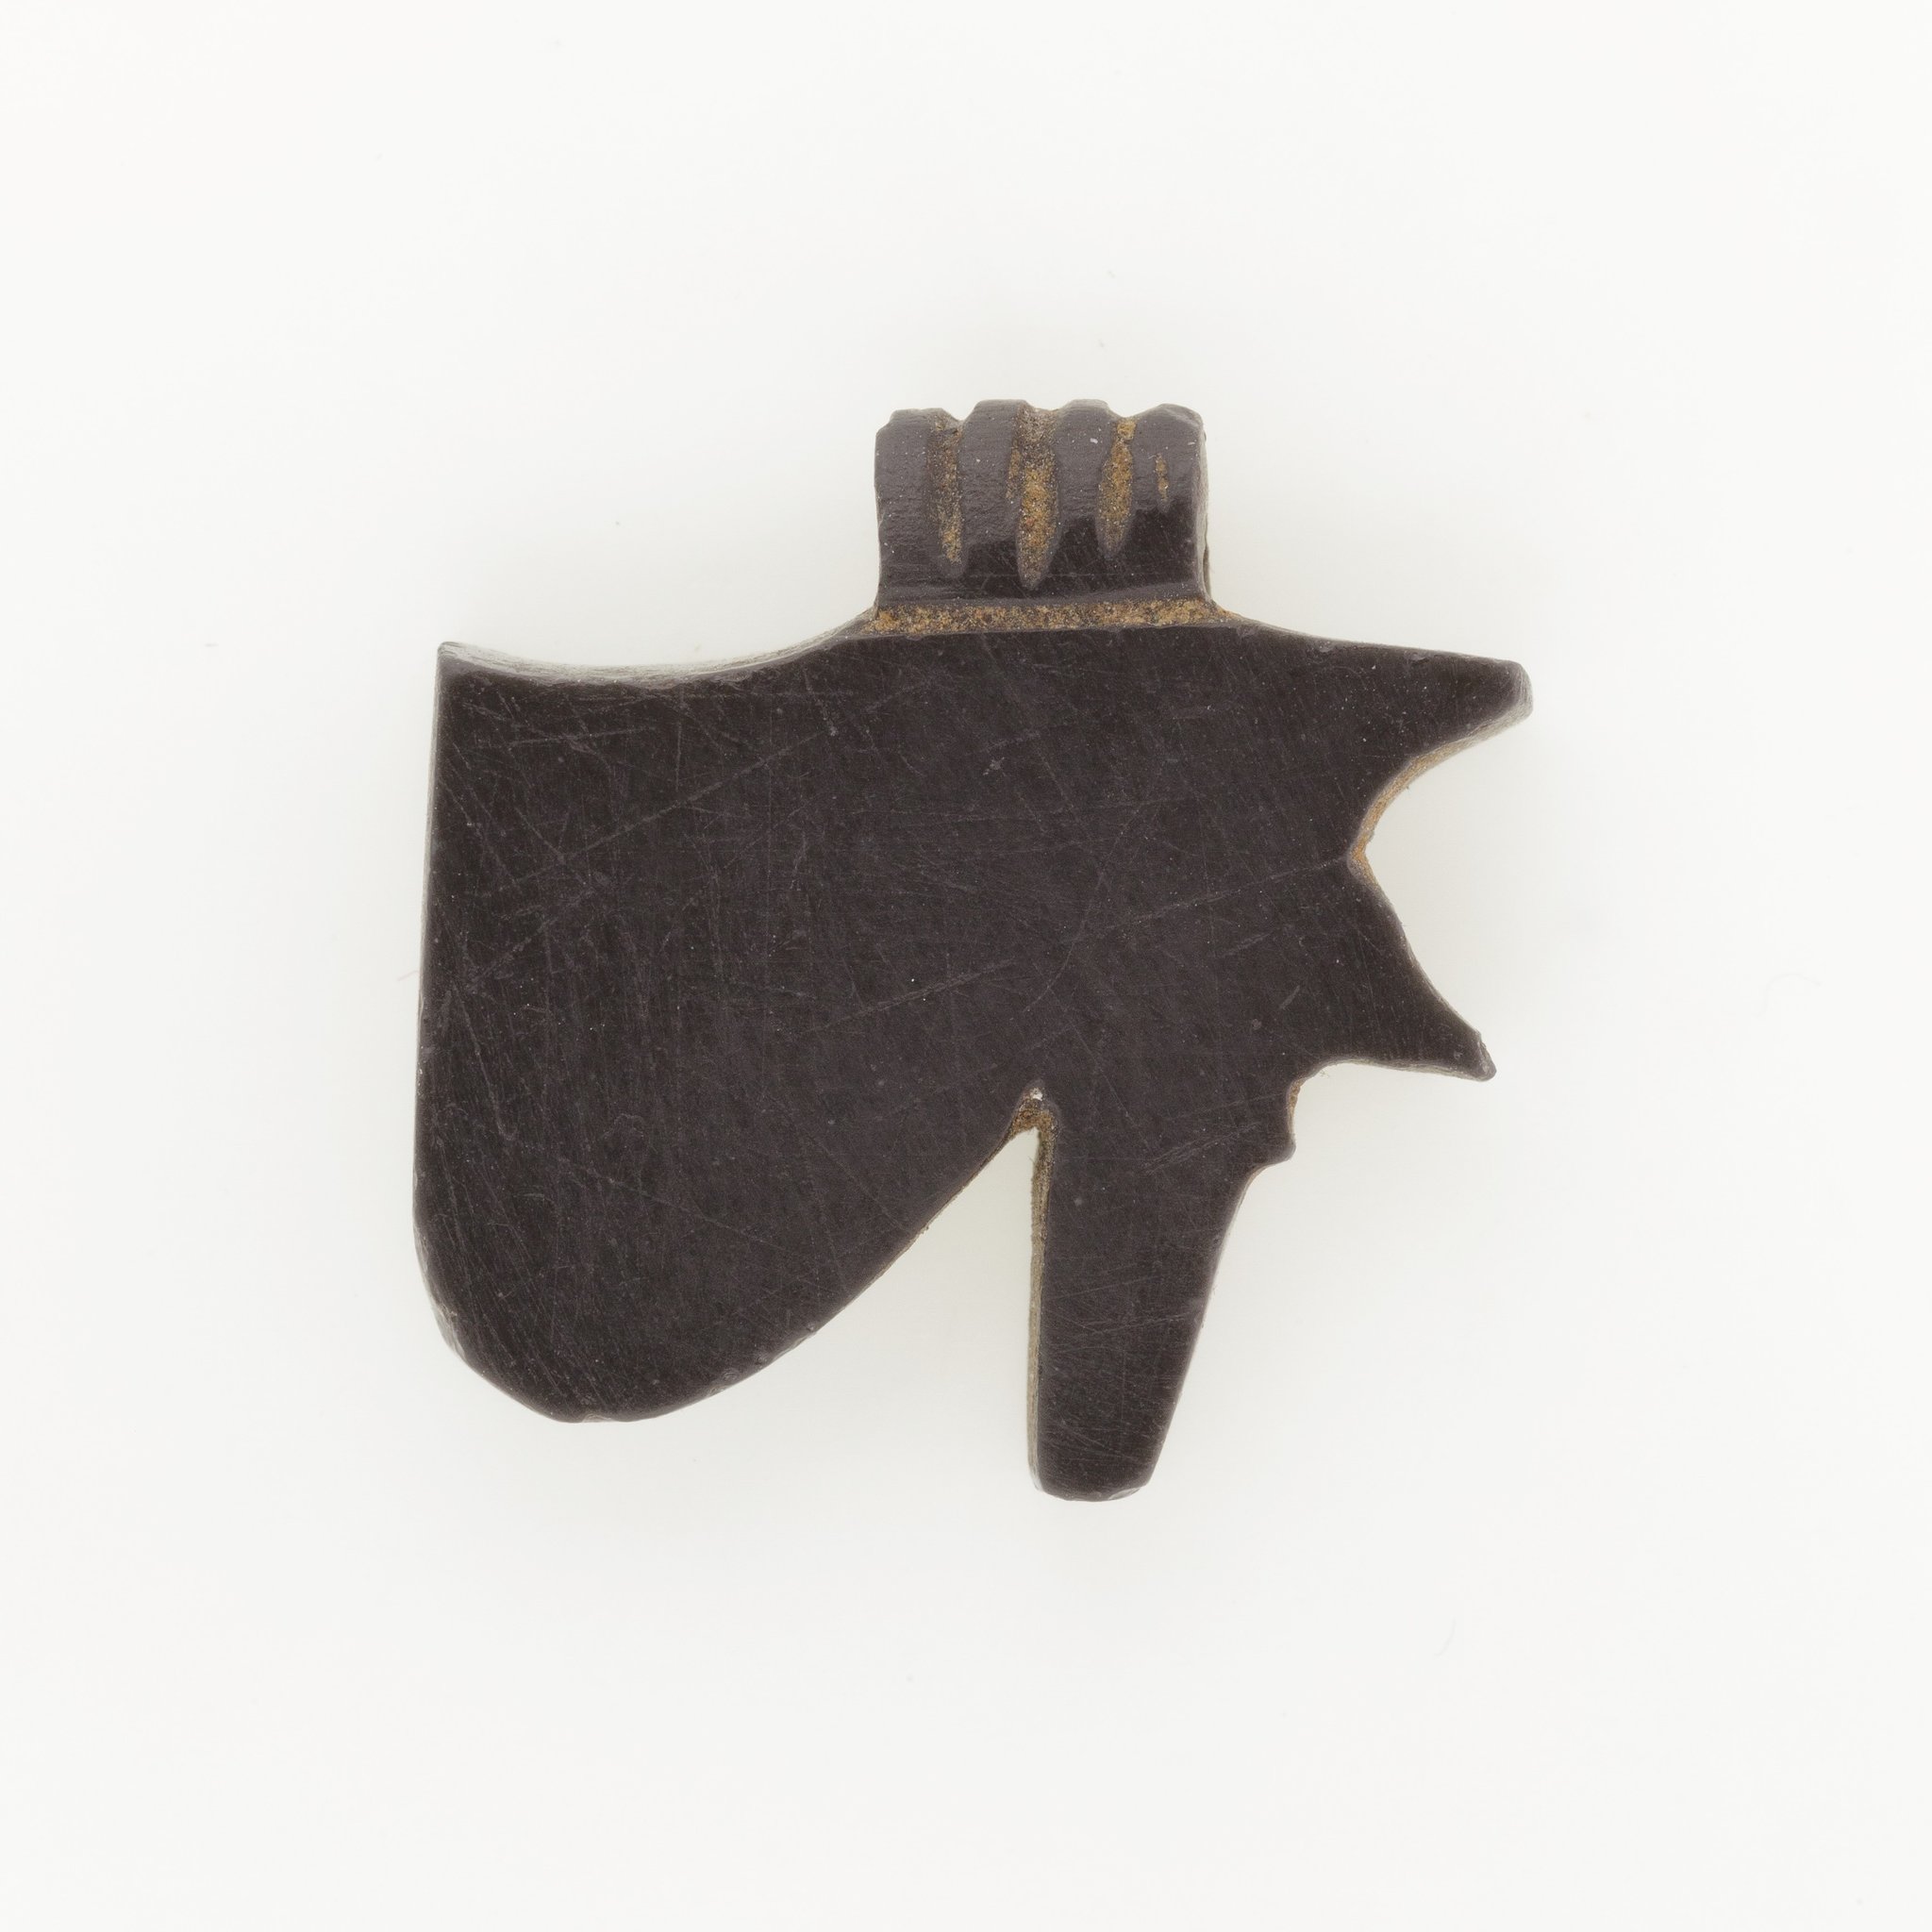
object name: amulet, wedjat eye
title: Wedjat eye amulet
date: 664-630 BCE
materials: obsidian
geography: egypt